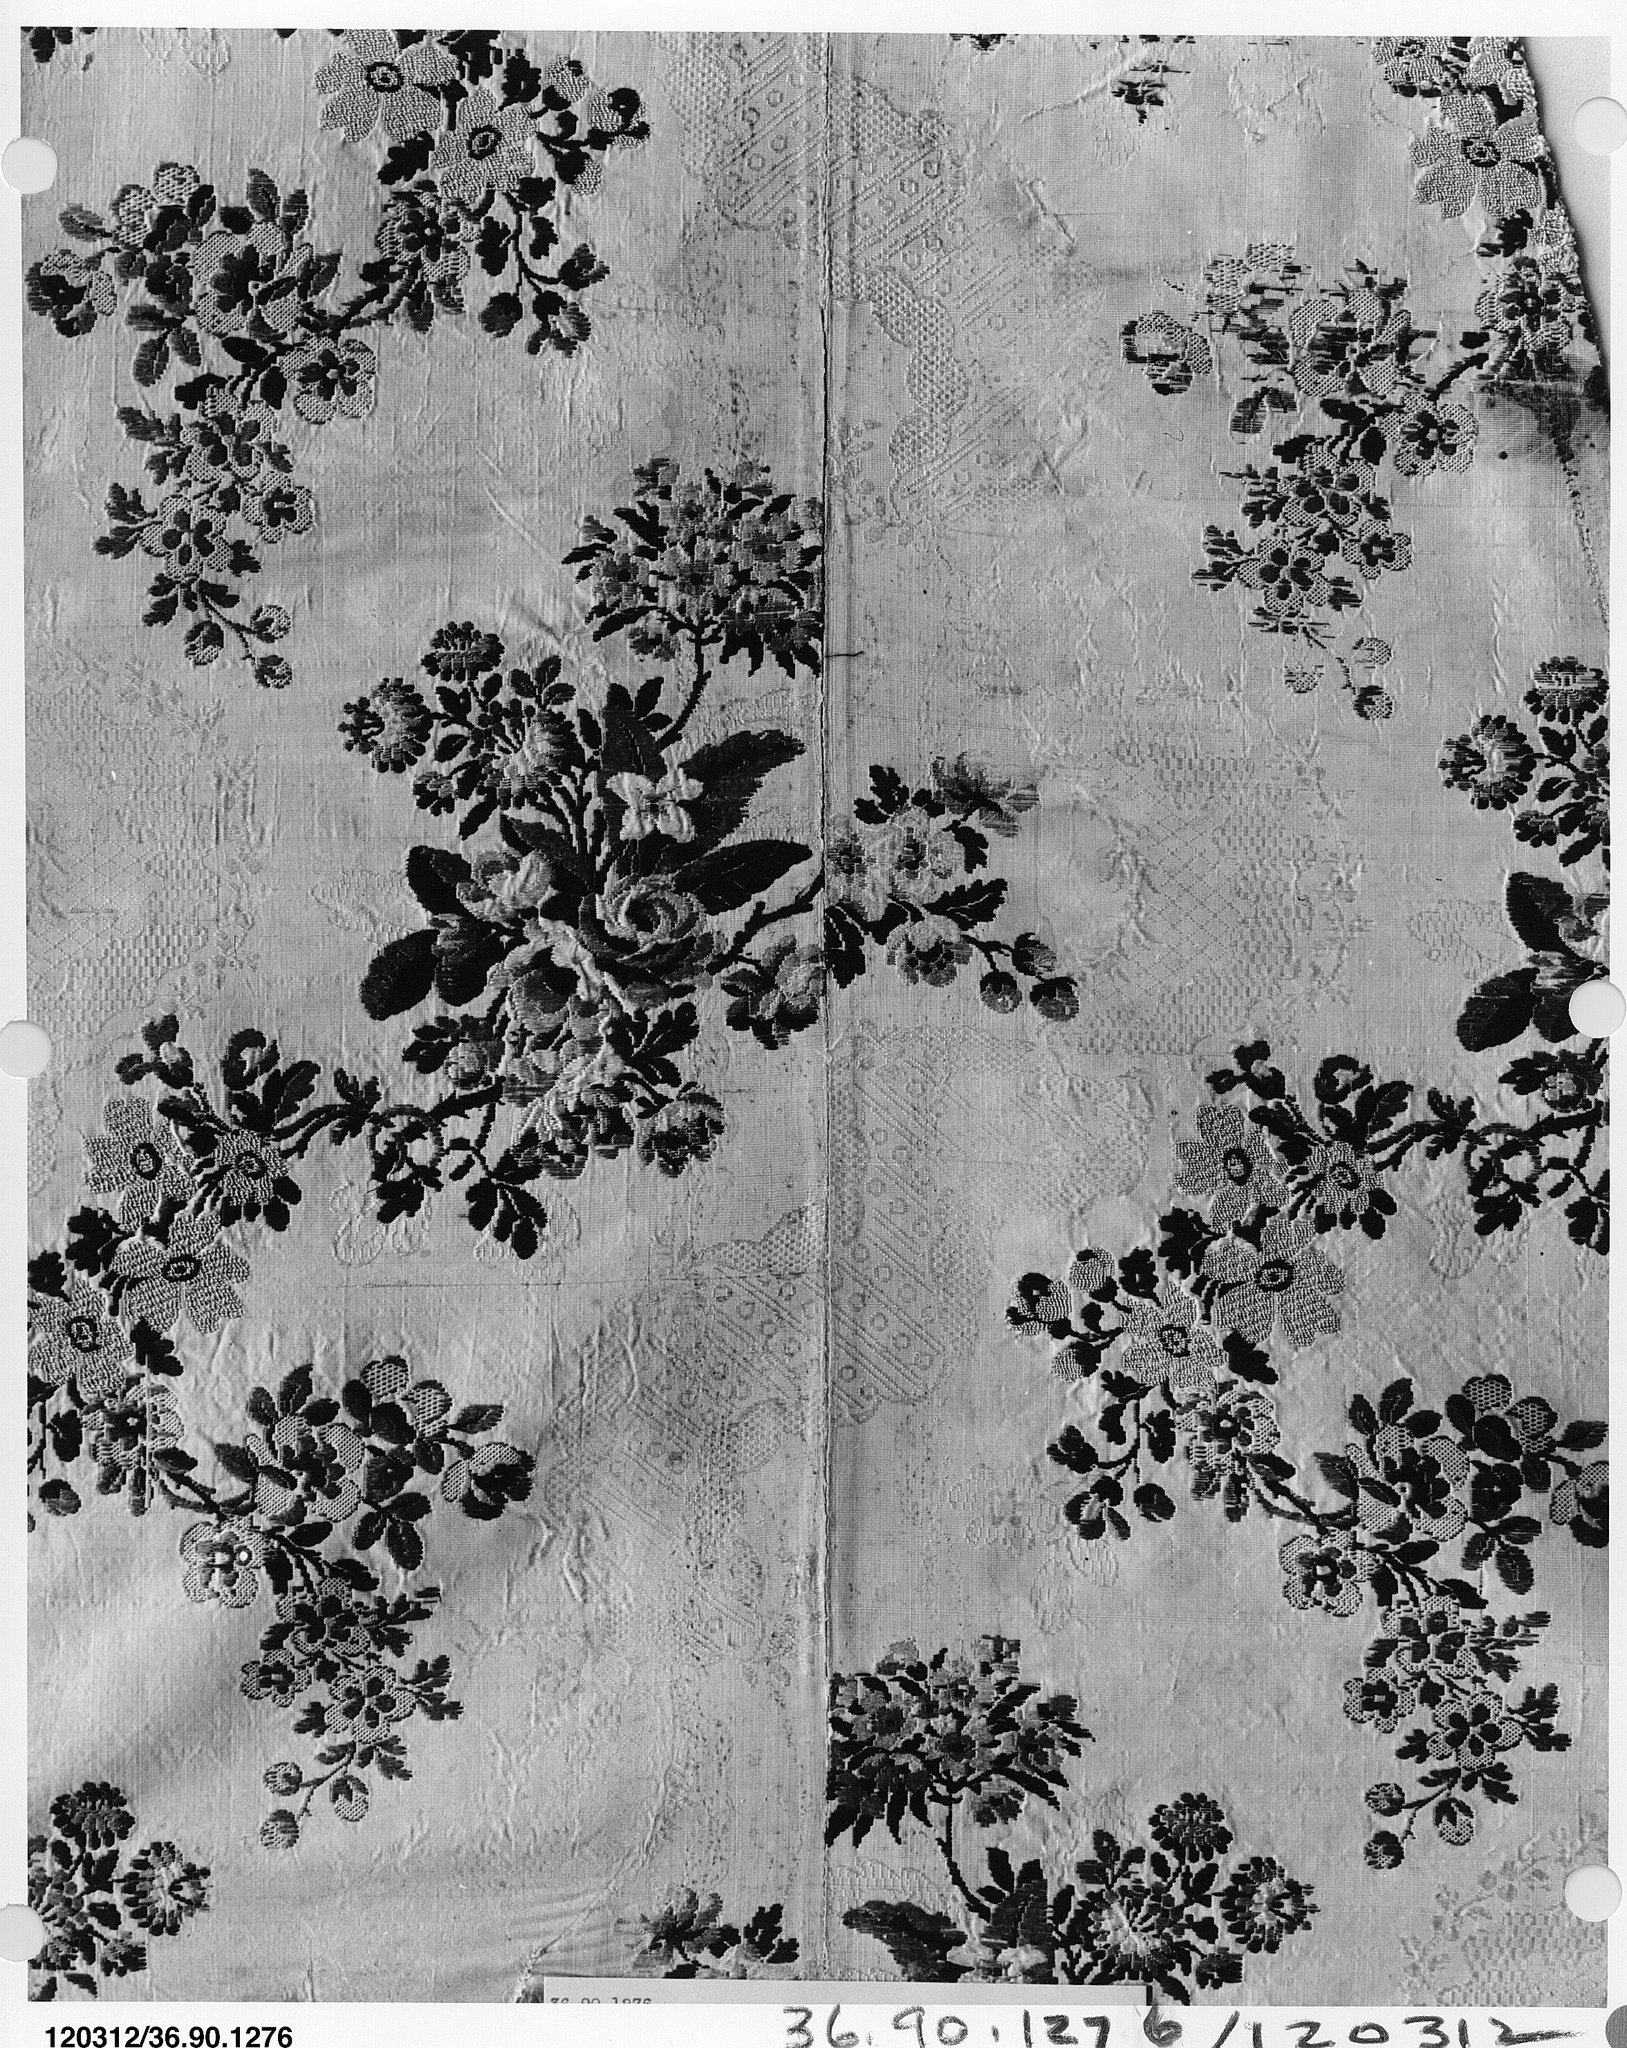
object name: piece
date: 1750-1760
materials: silk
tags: flowers,leaves